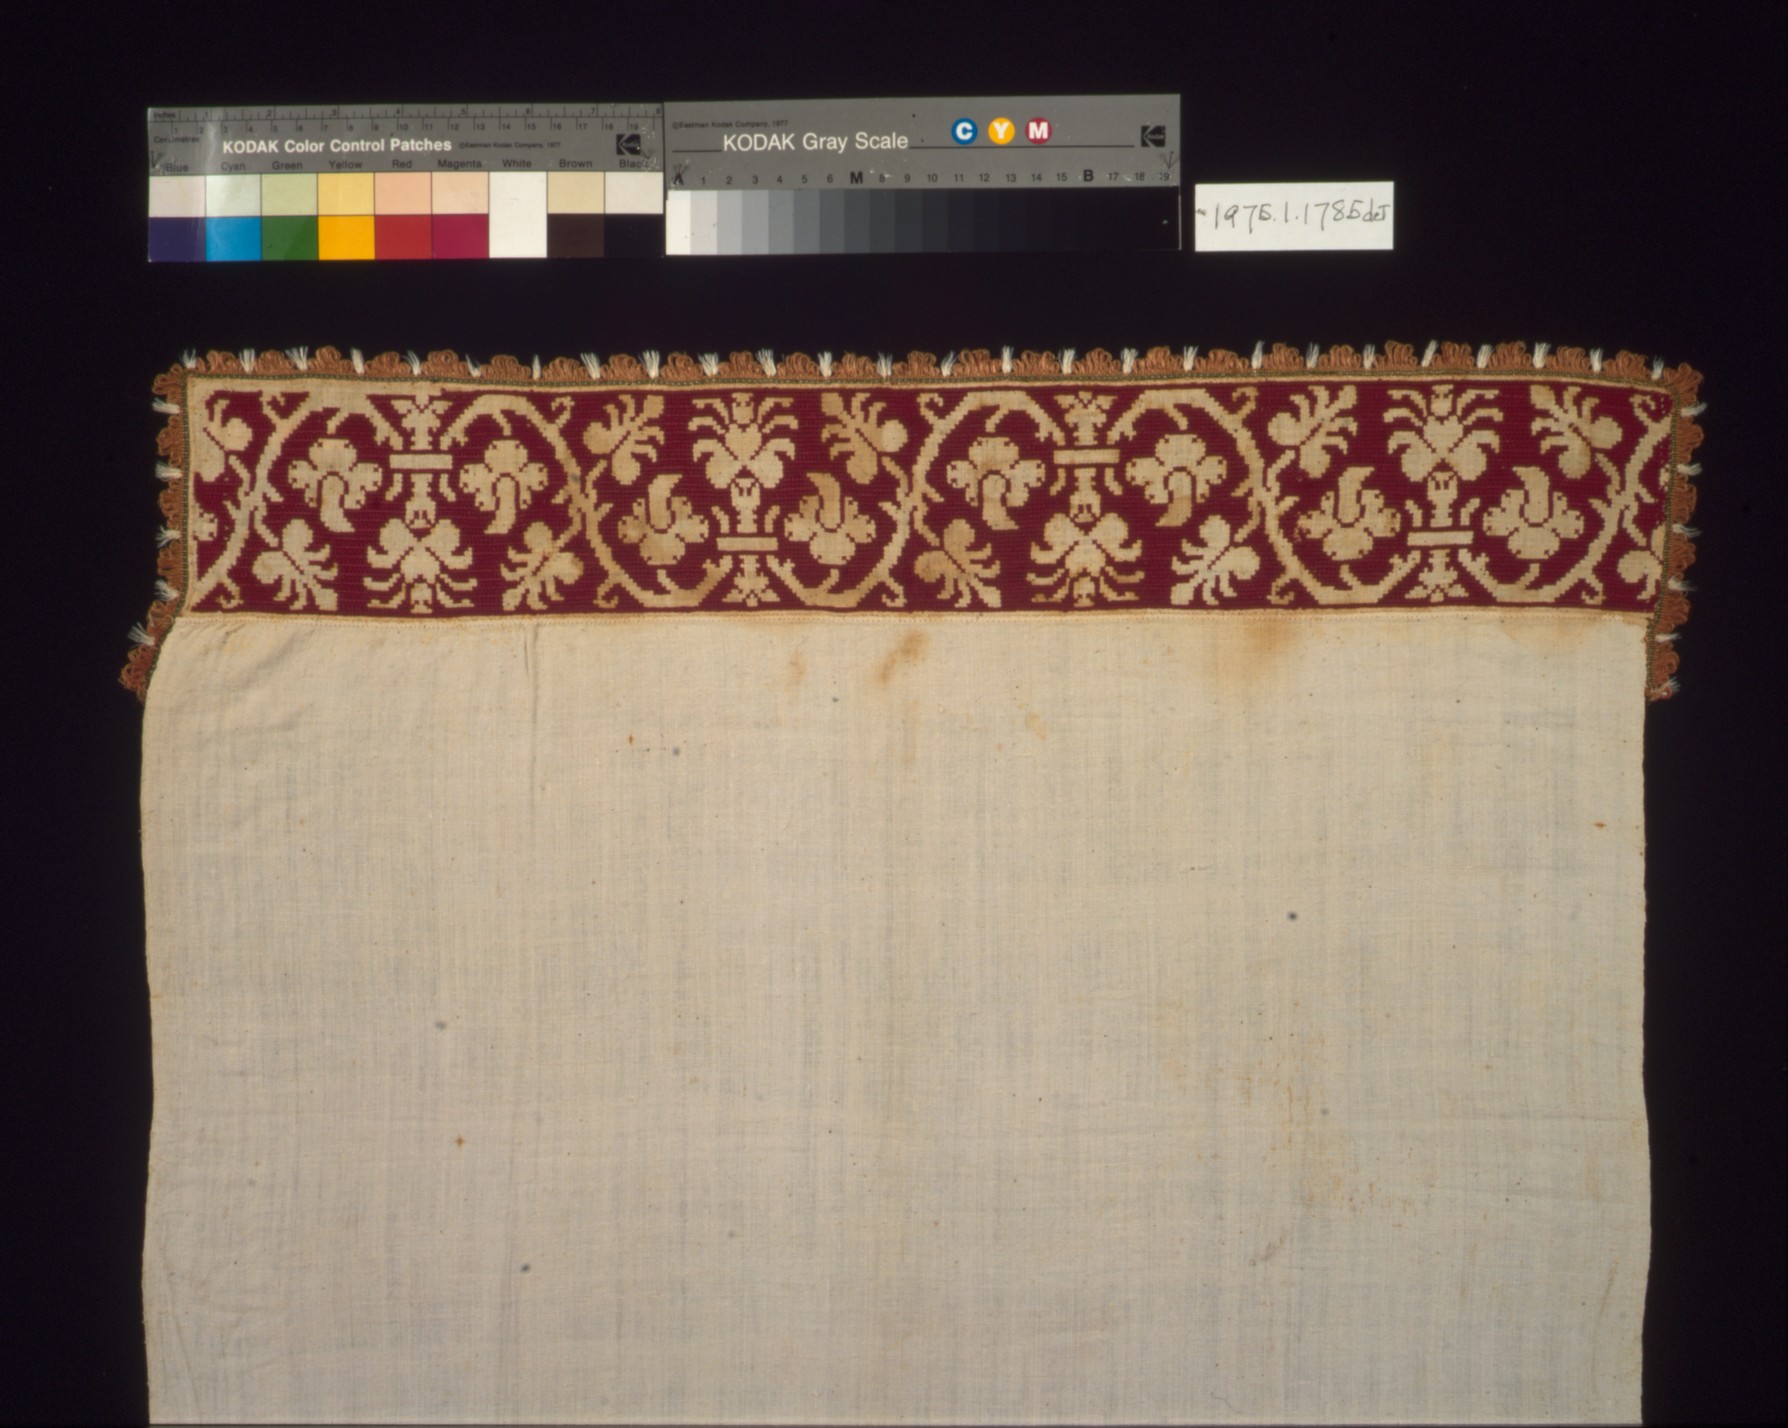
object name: towel or textile cover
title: Towel or Cover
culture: italian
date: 1601-1700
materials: linen, silk